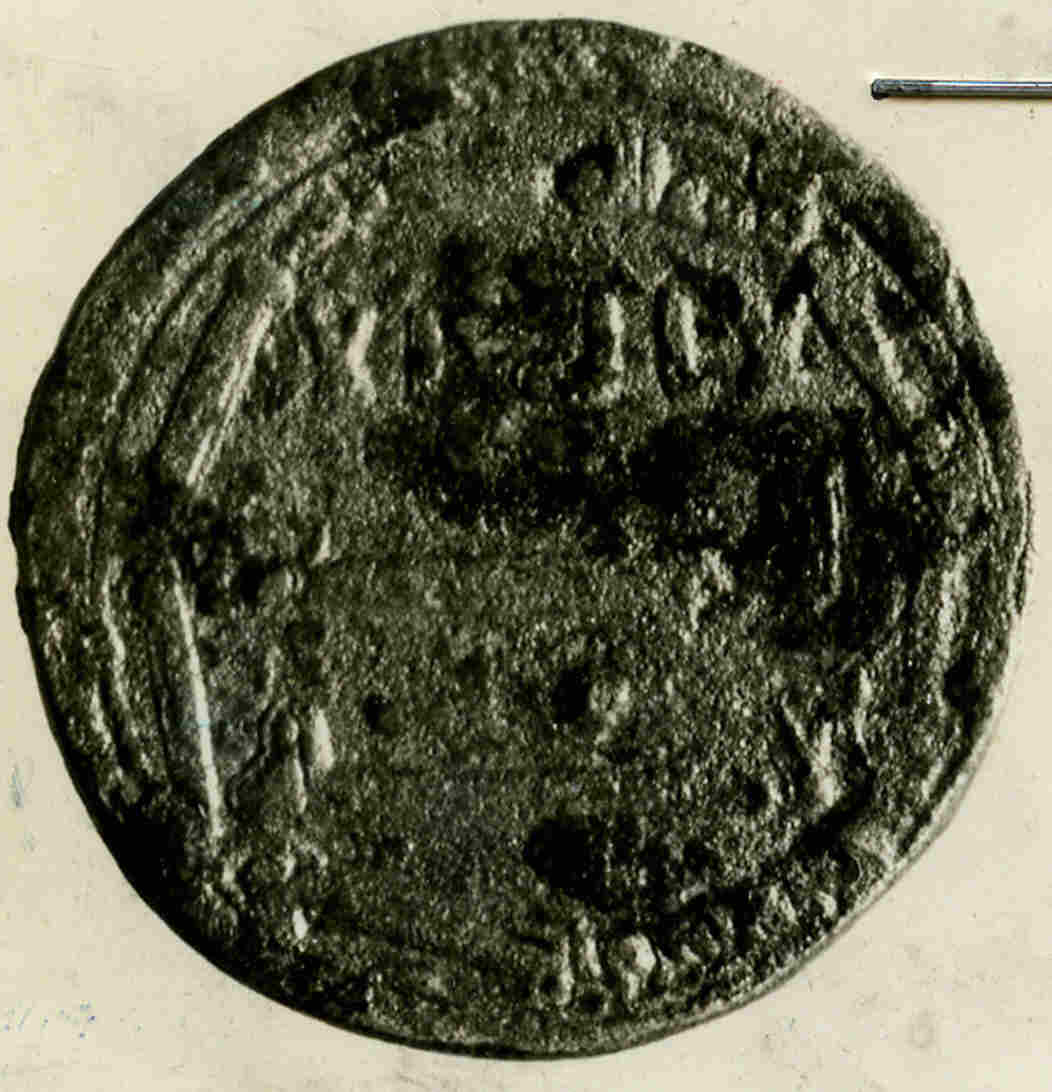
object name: coin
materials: copper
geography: al-muhammadiyya